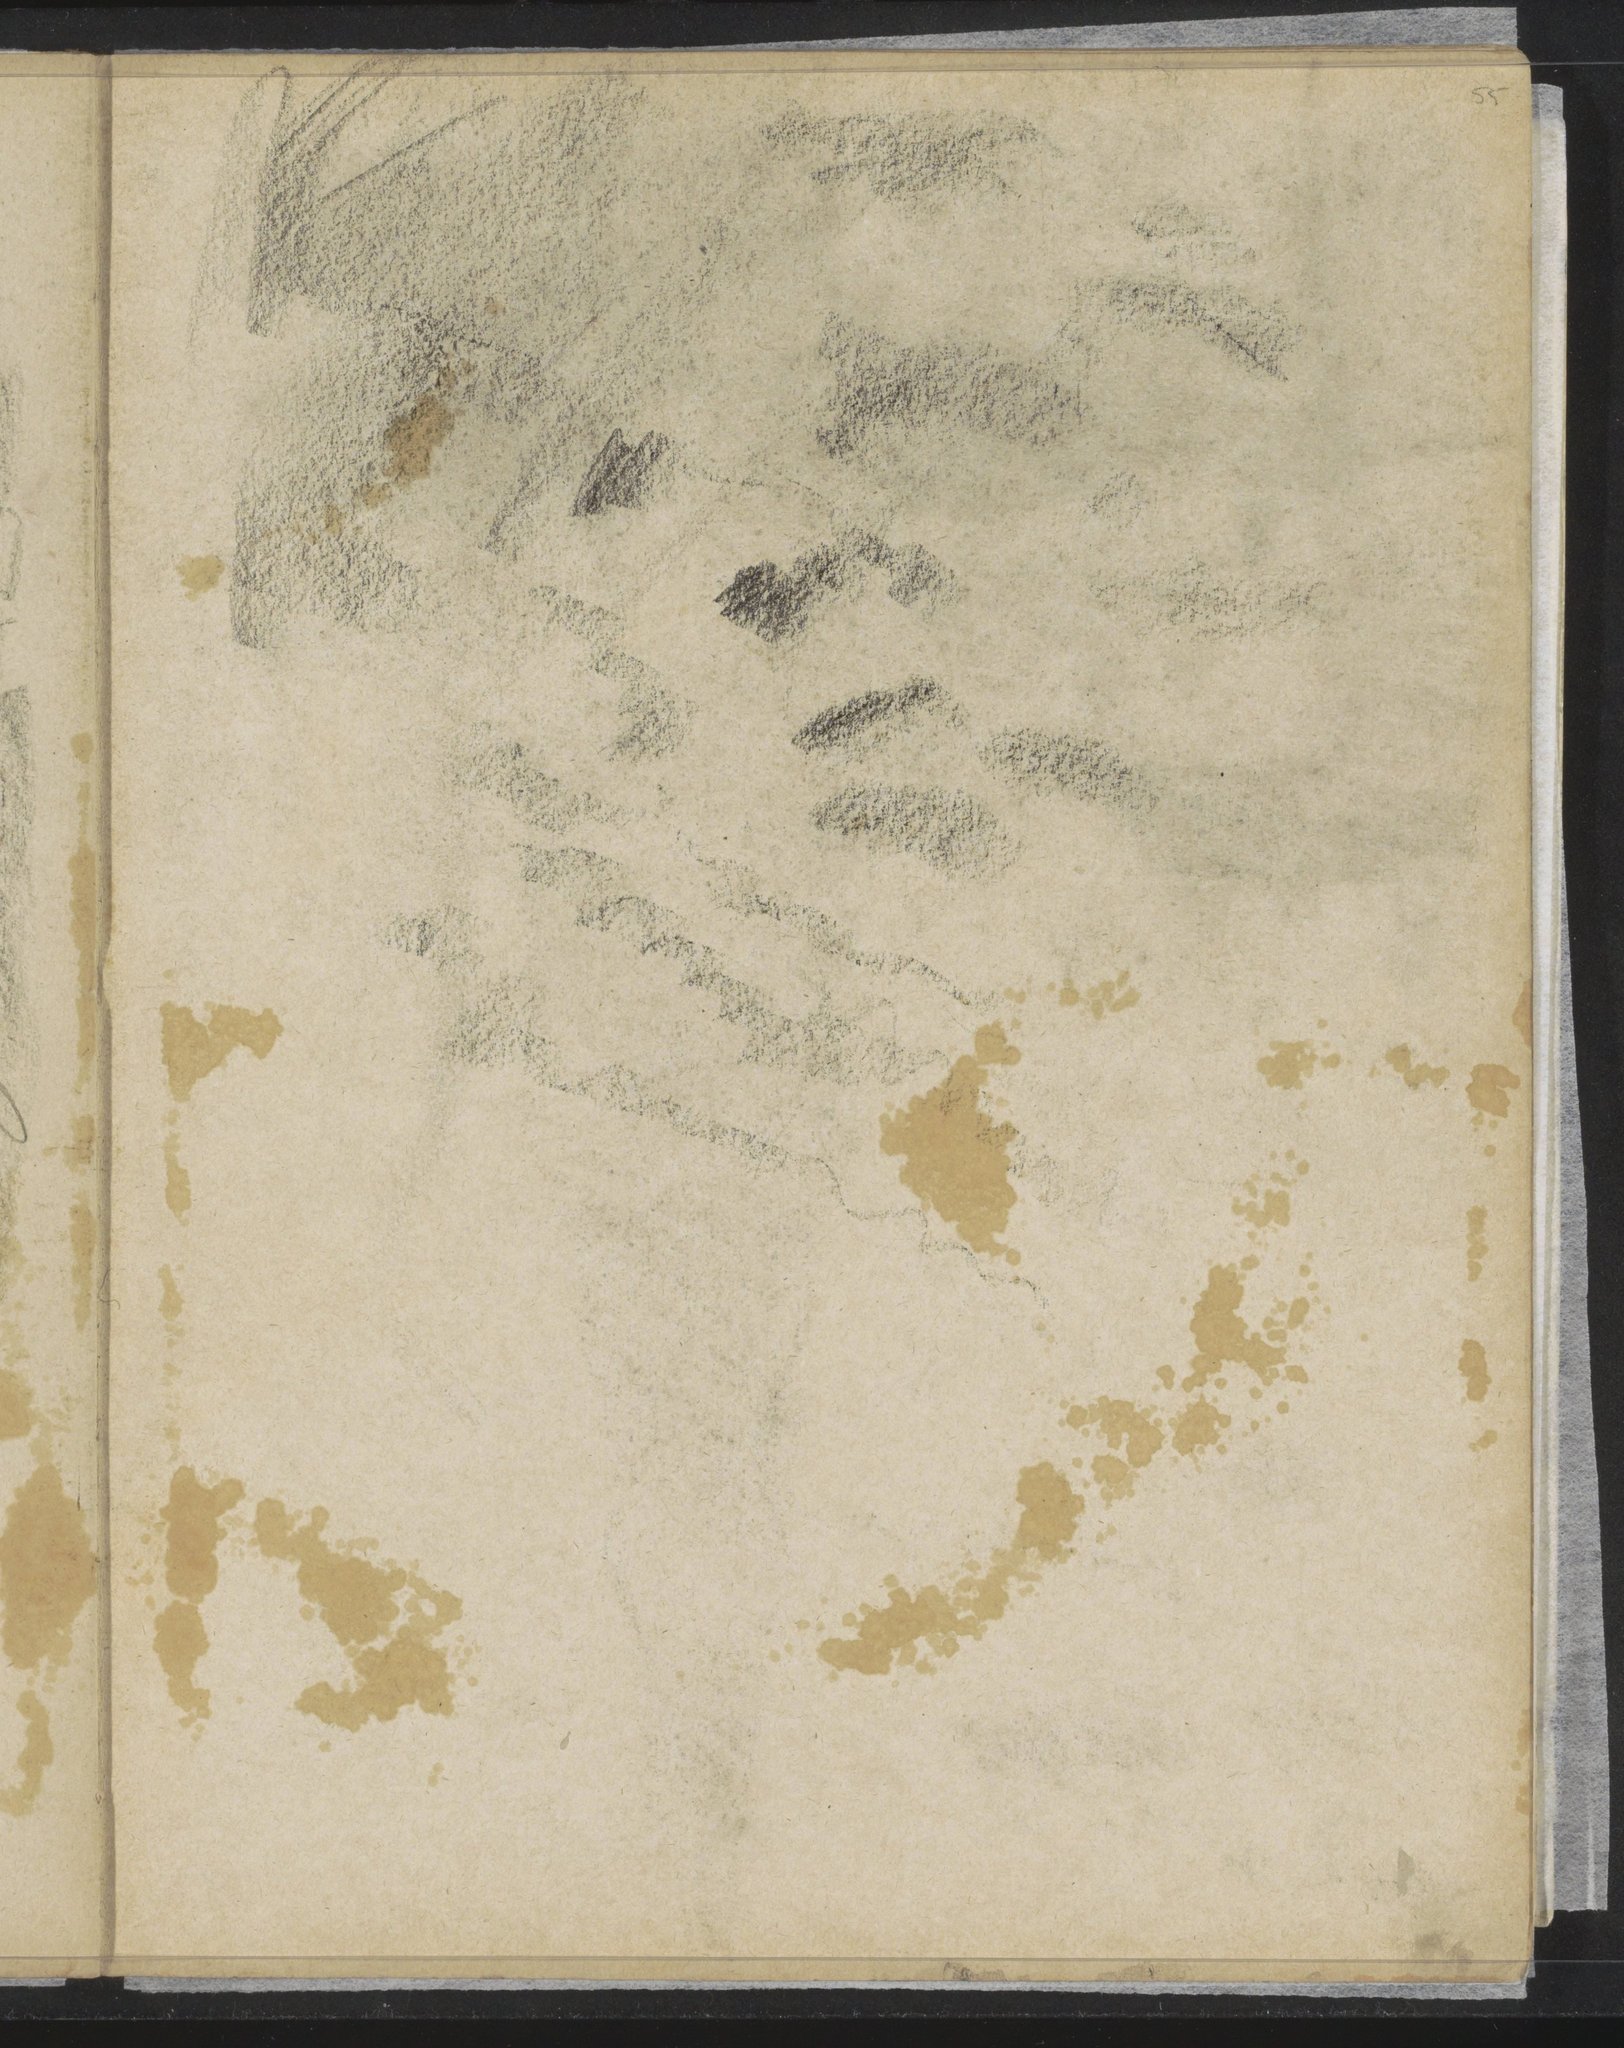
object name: sketchbook leaf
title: Studie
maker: willem witsen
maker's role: draughtsman, painter, print maker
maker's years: 1860-1923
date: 1887-1891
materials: chalk, paper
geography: amsterdam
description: Pagina 55 uit een schetsboek met 29 bladen.